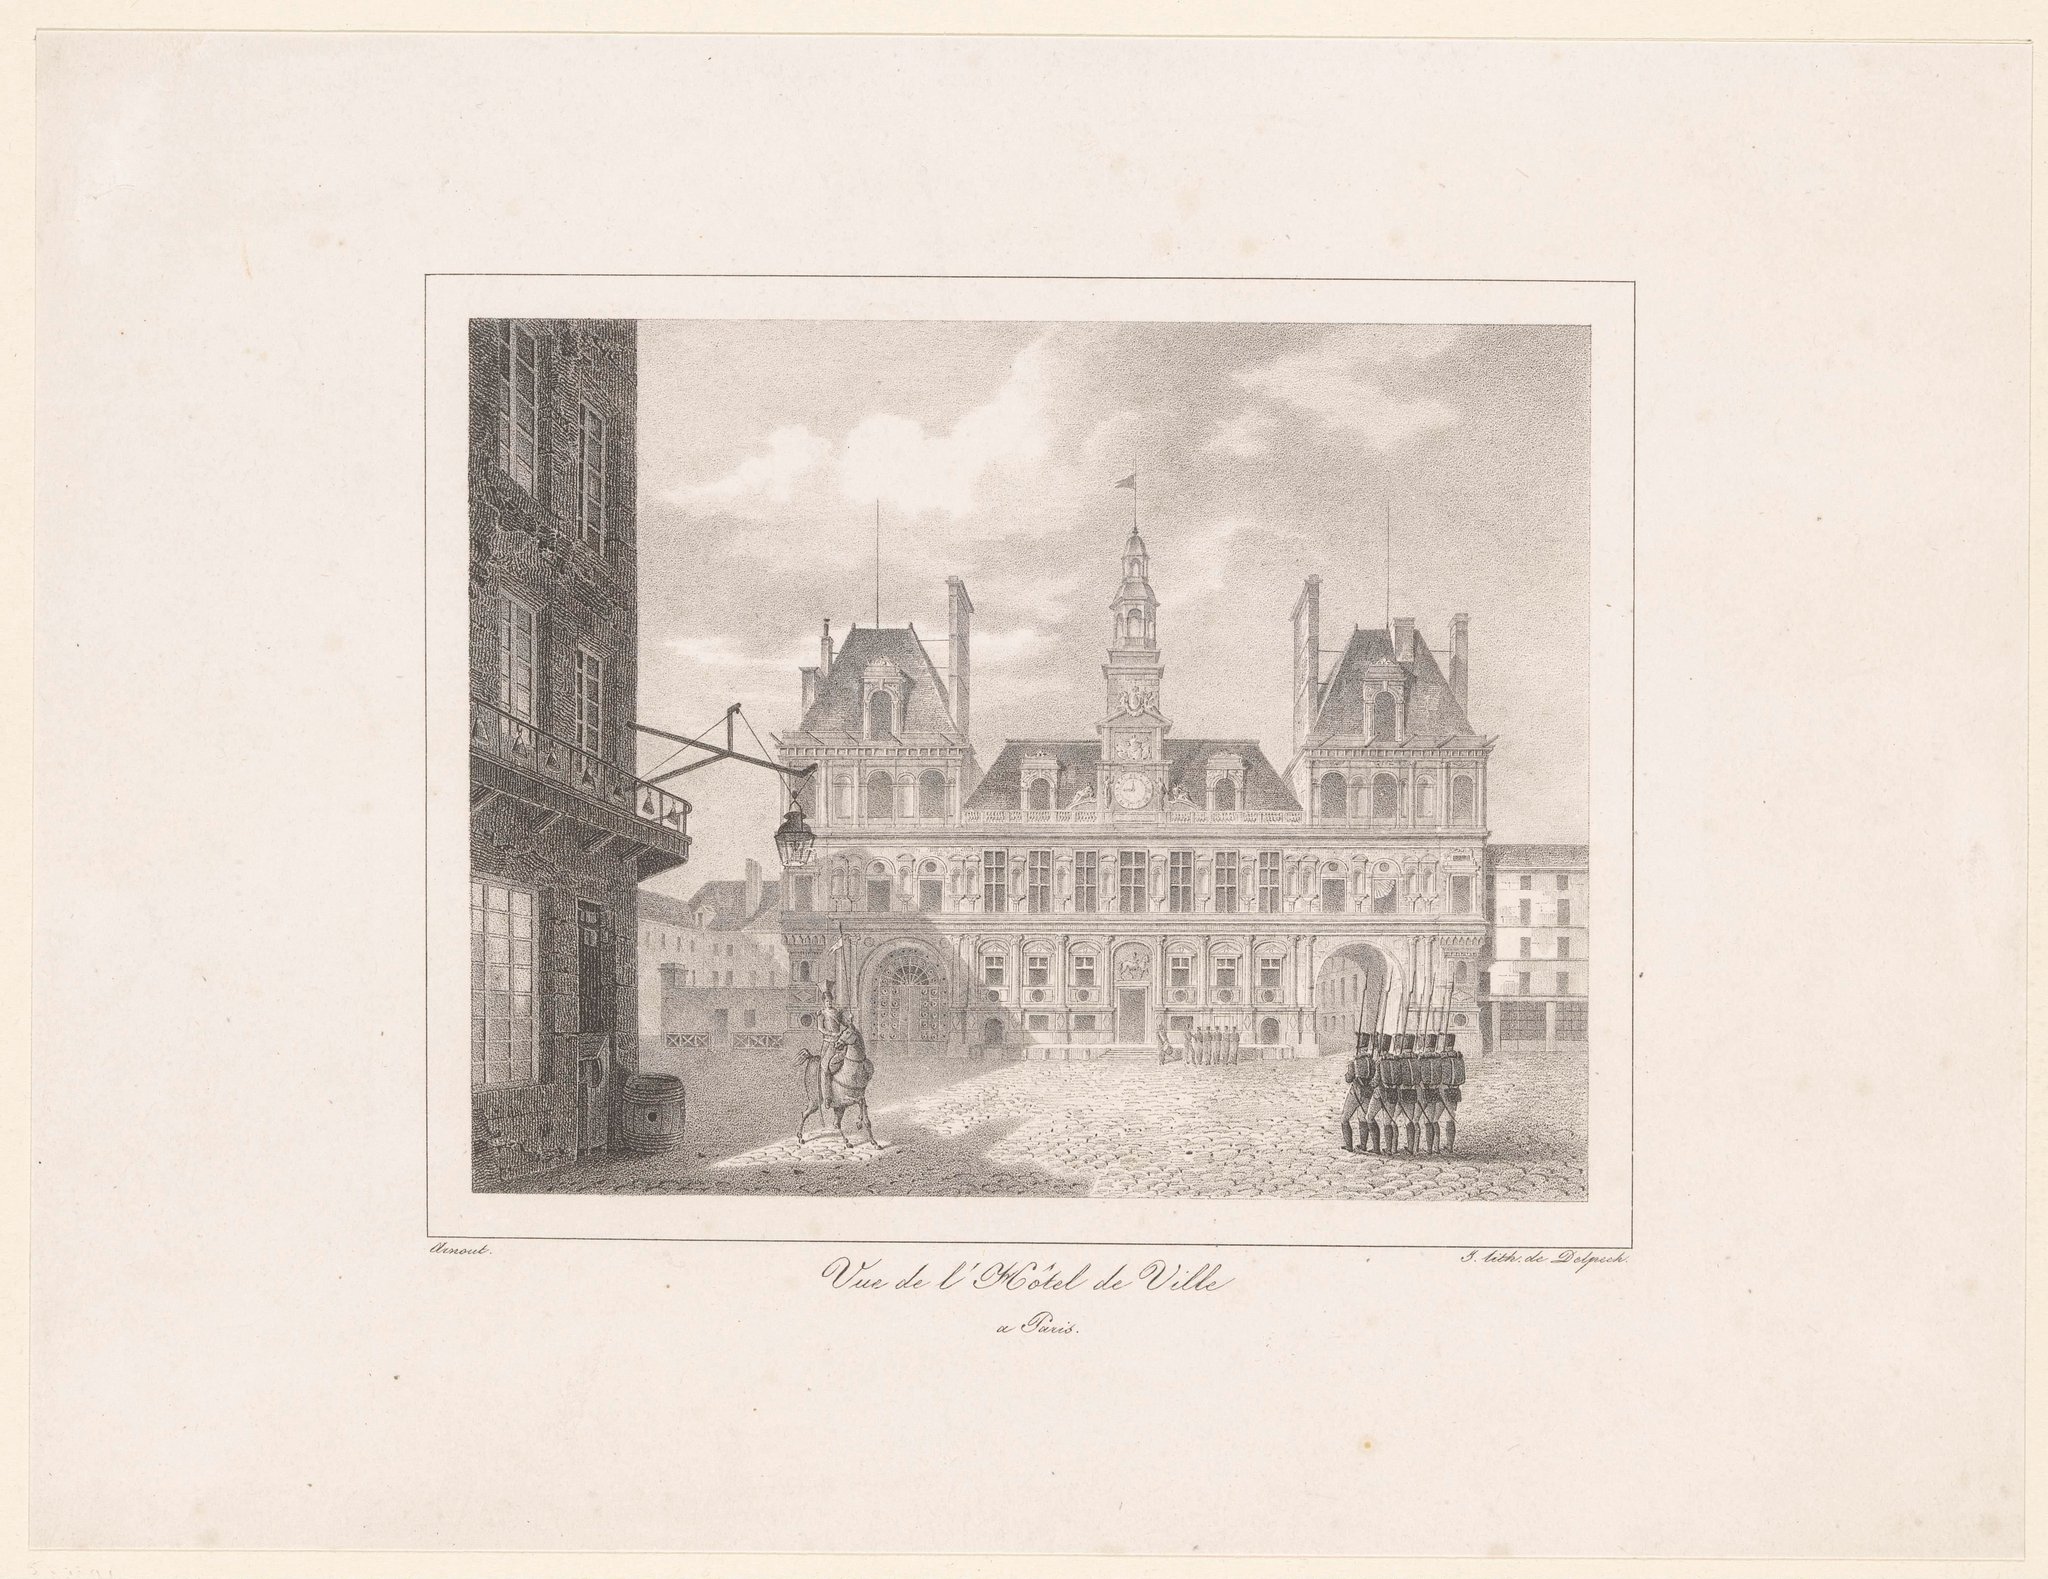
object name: print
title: Zicht op het stadhuis van Parijs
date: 1820-1821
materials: paper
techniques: lithograph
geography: paris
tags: townhall, paris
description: De serie waar deze prent deel van uit maakt, bestaat waarschijnlijk uit dertig prenten.